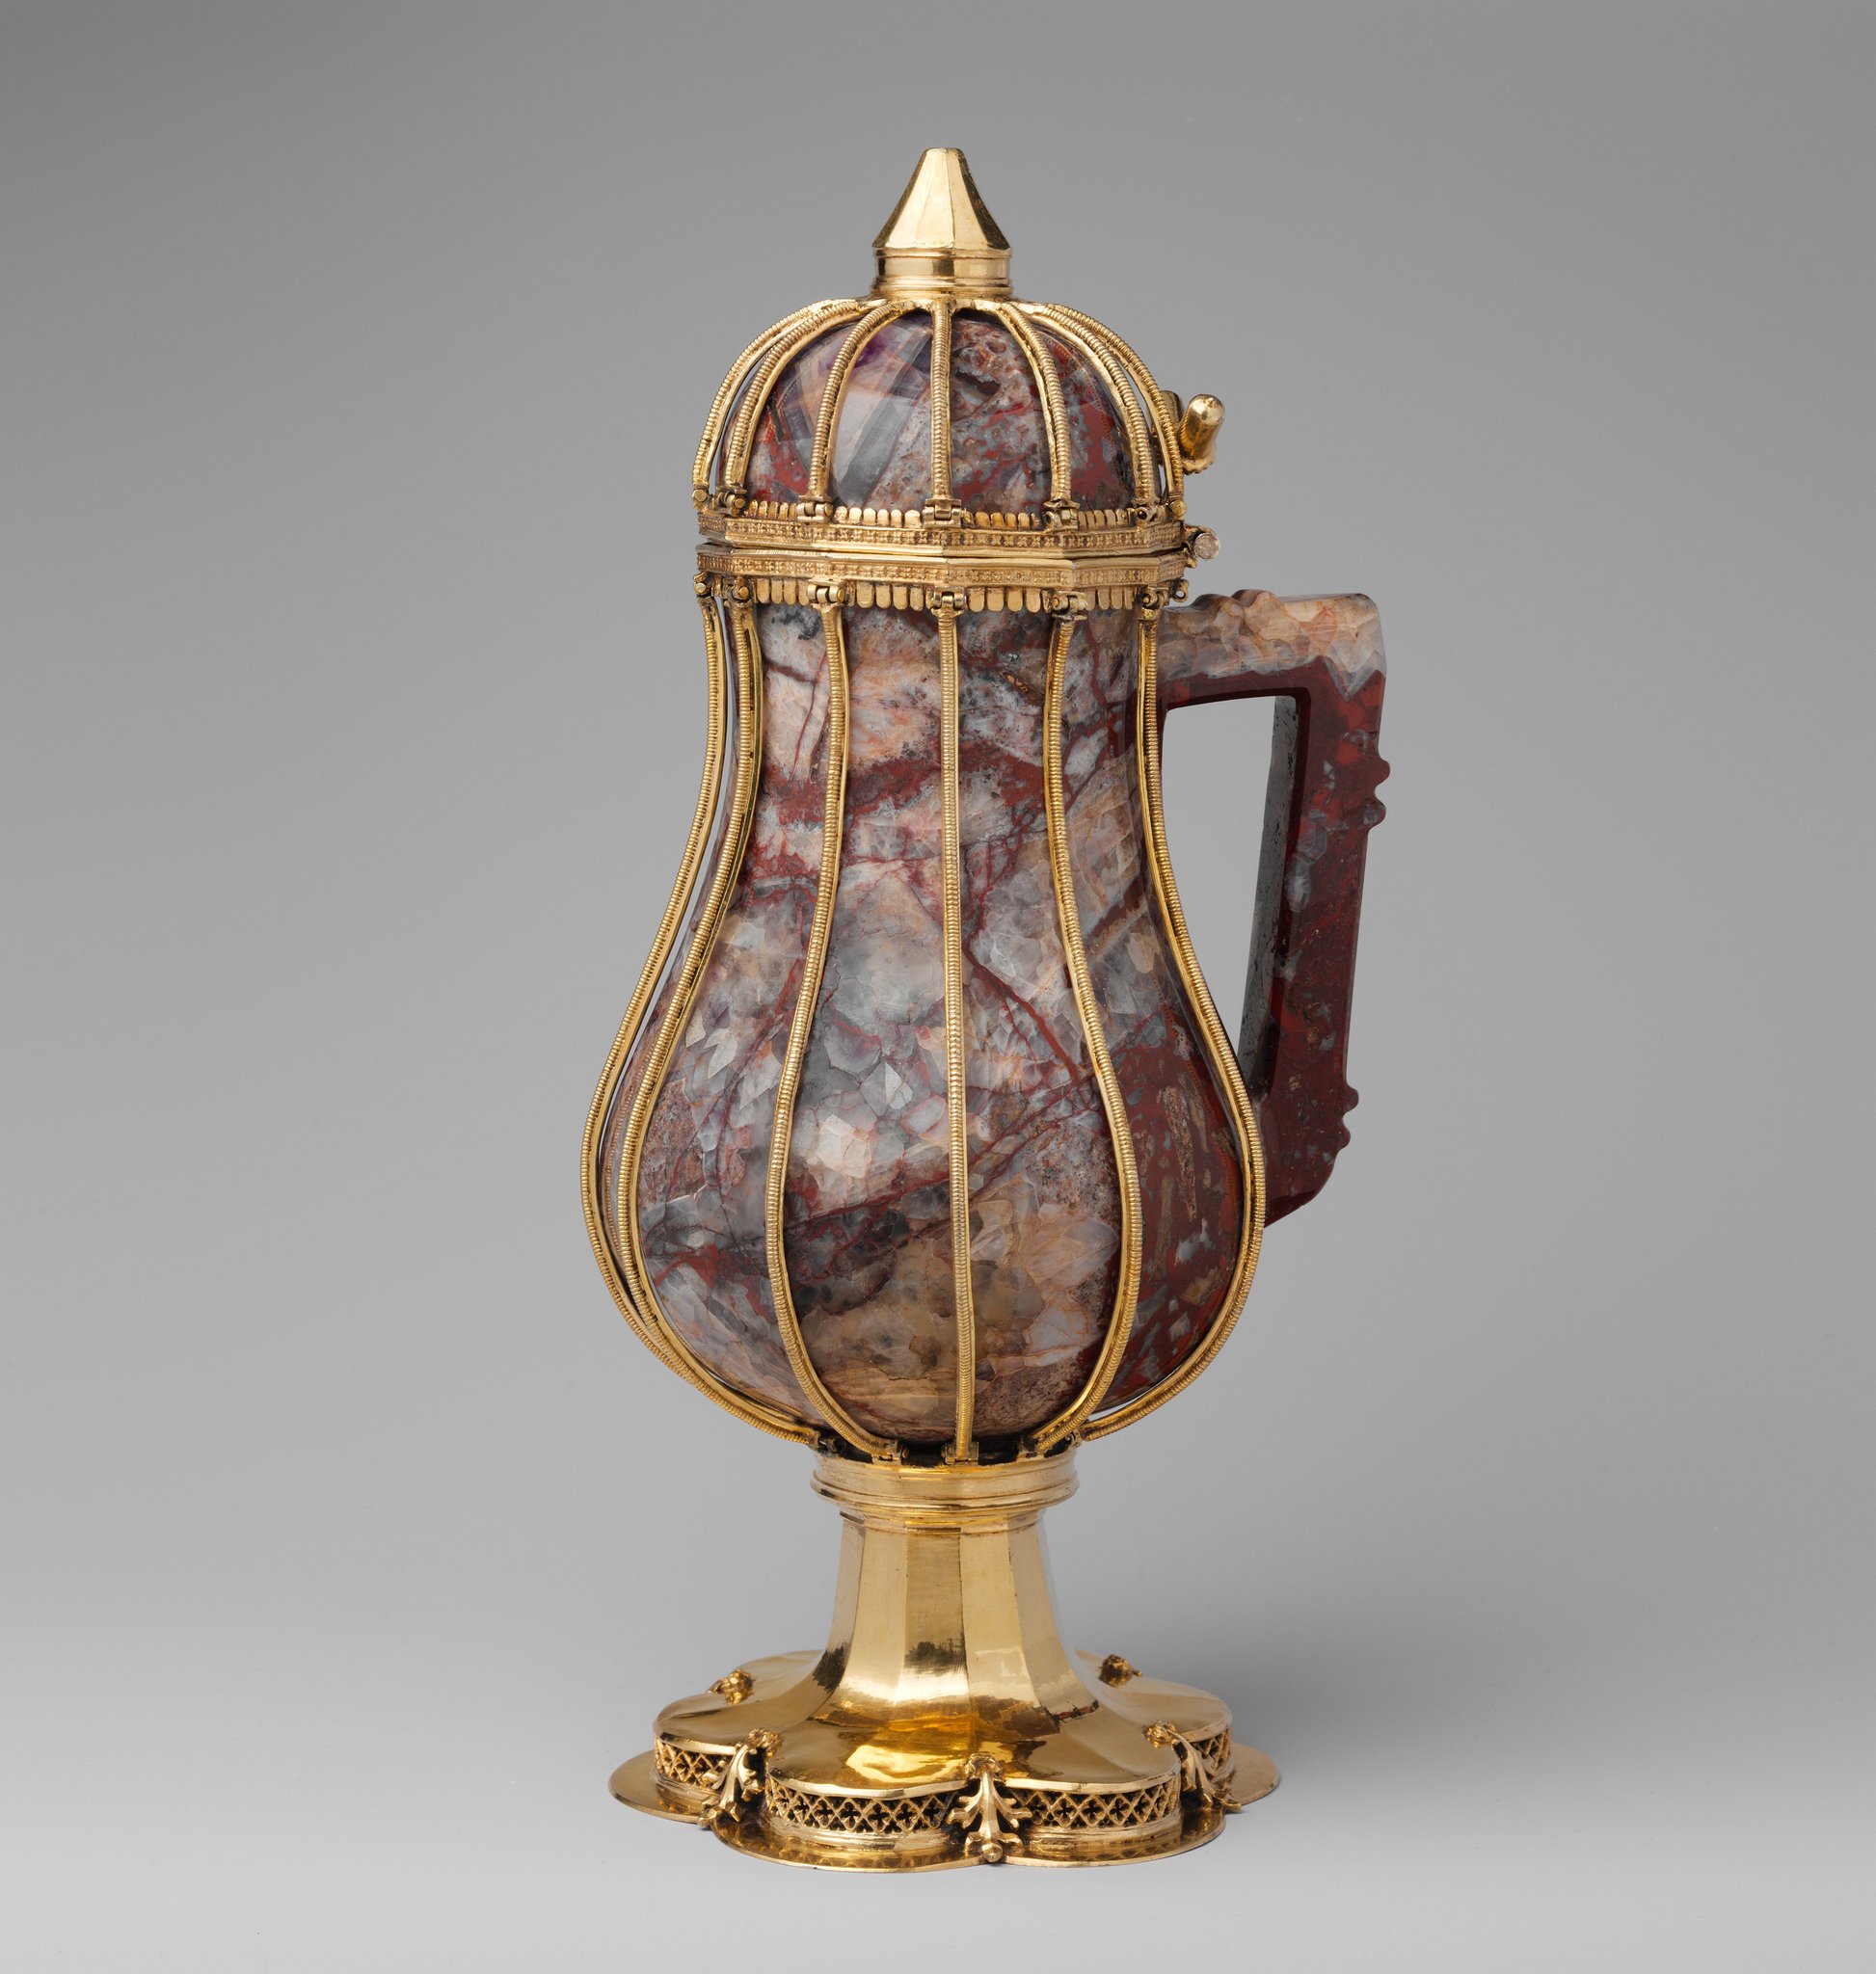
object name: ewer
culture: bohemian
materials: jasper, silver gilt